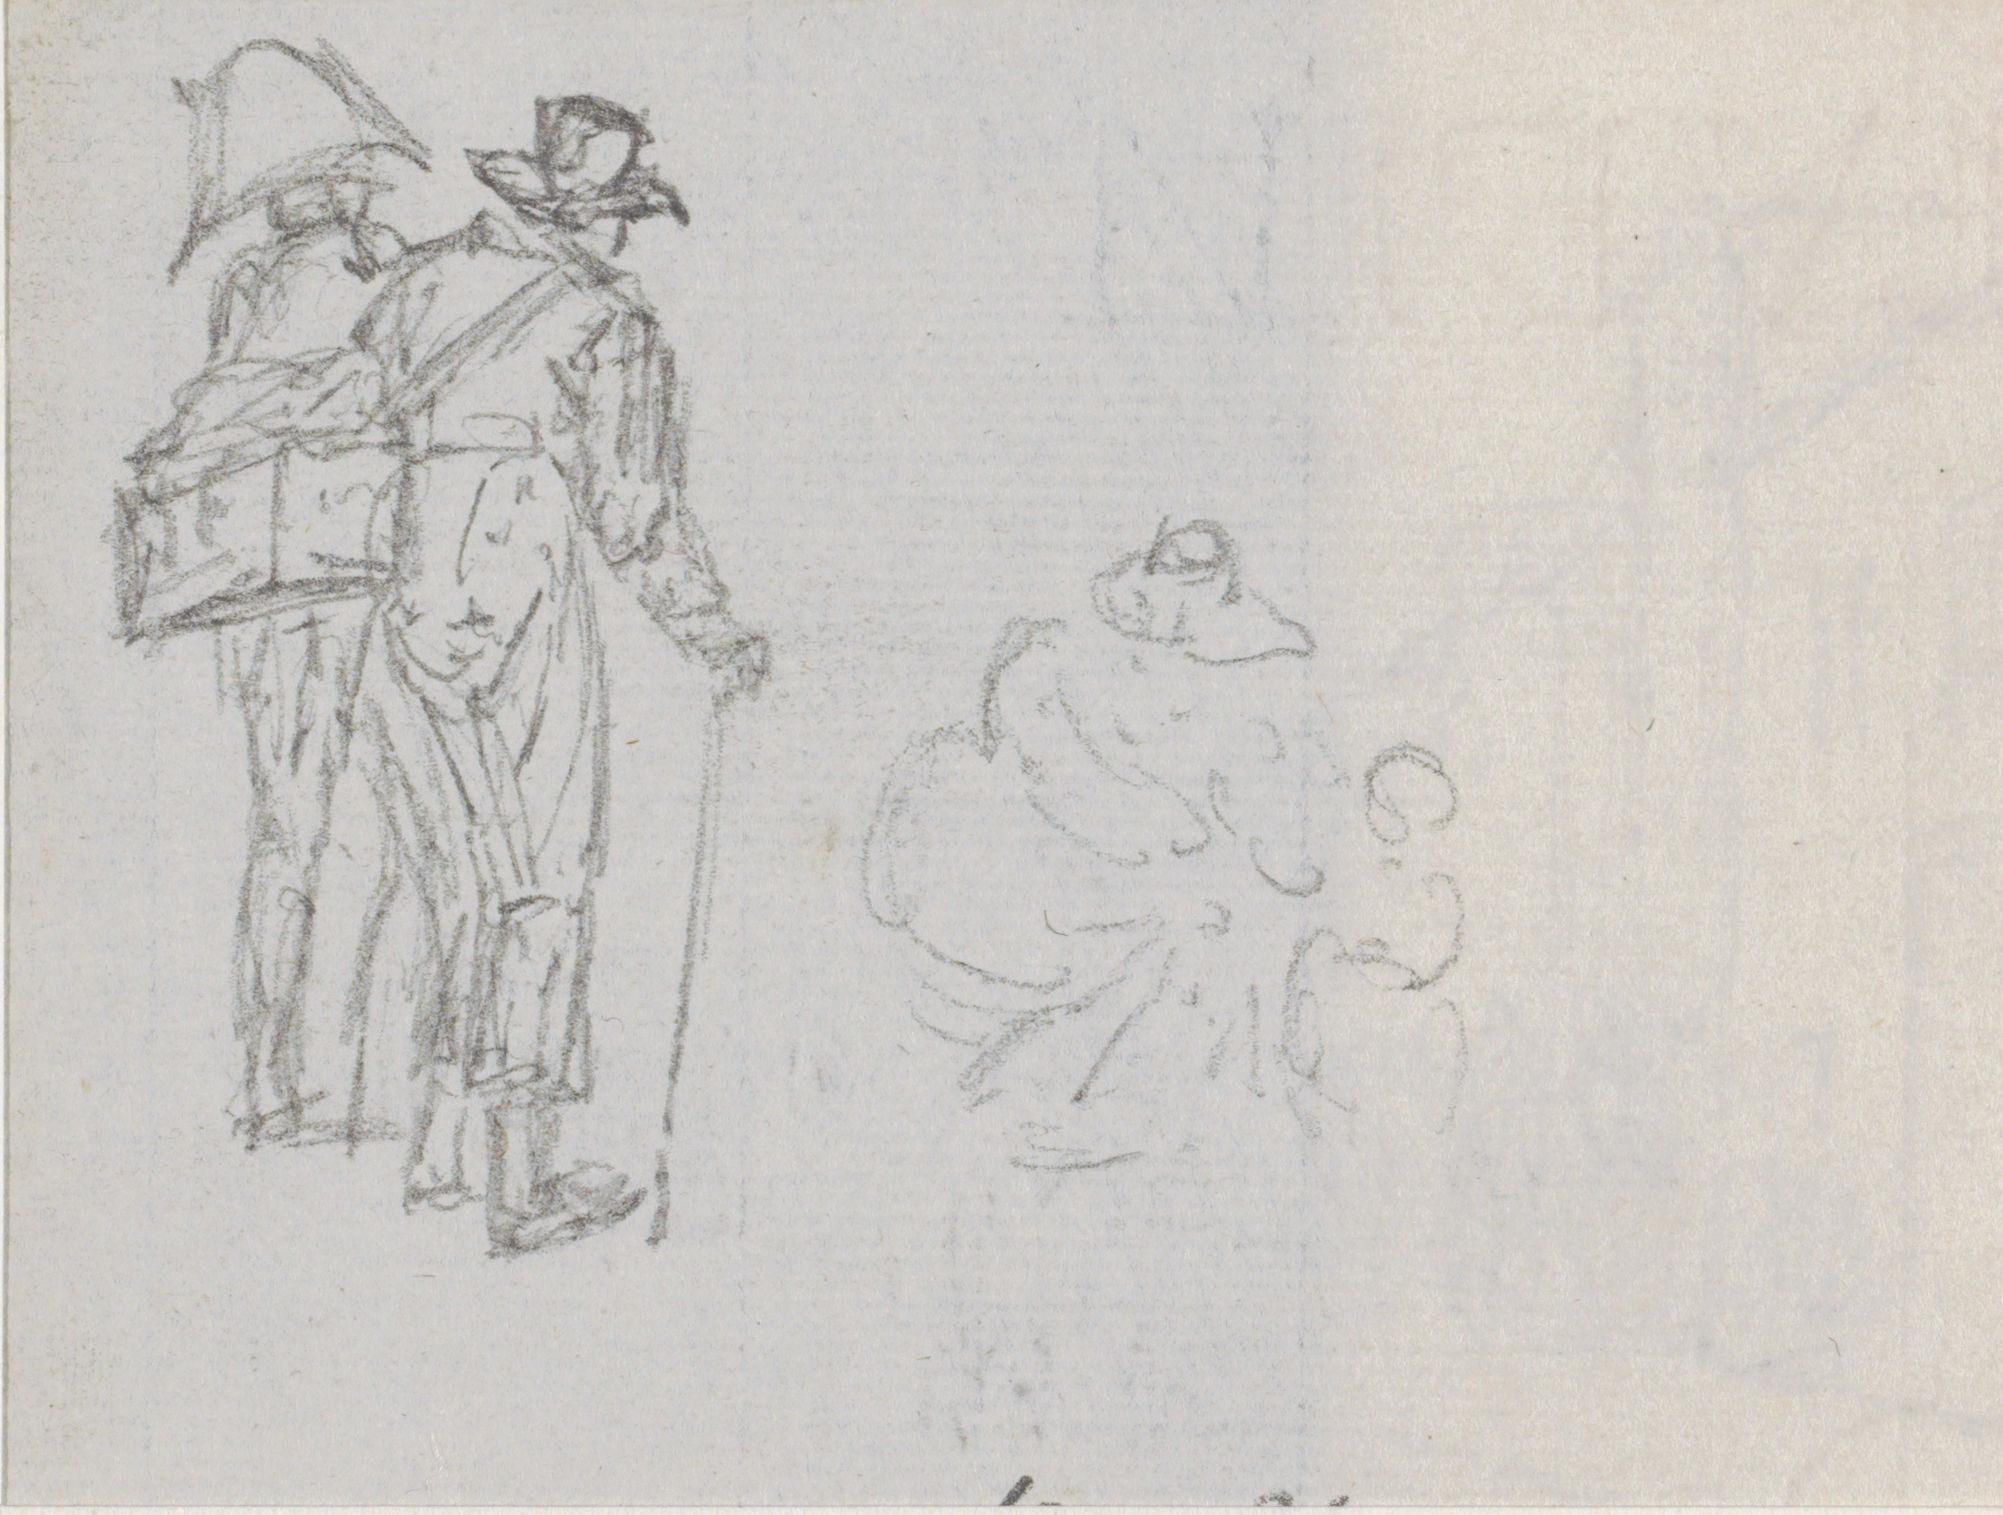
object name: drawing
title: Gendarme met een man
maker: georges michel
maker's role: draughtsman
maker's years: 1763-1843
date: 1773-1843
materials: paper, pencil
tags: policeman, constable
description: Een van 120 tekeningen, afkomstig uit een 19e eeuws album met tekeningen van Georges Michel.